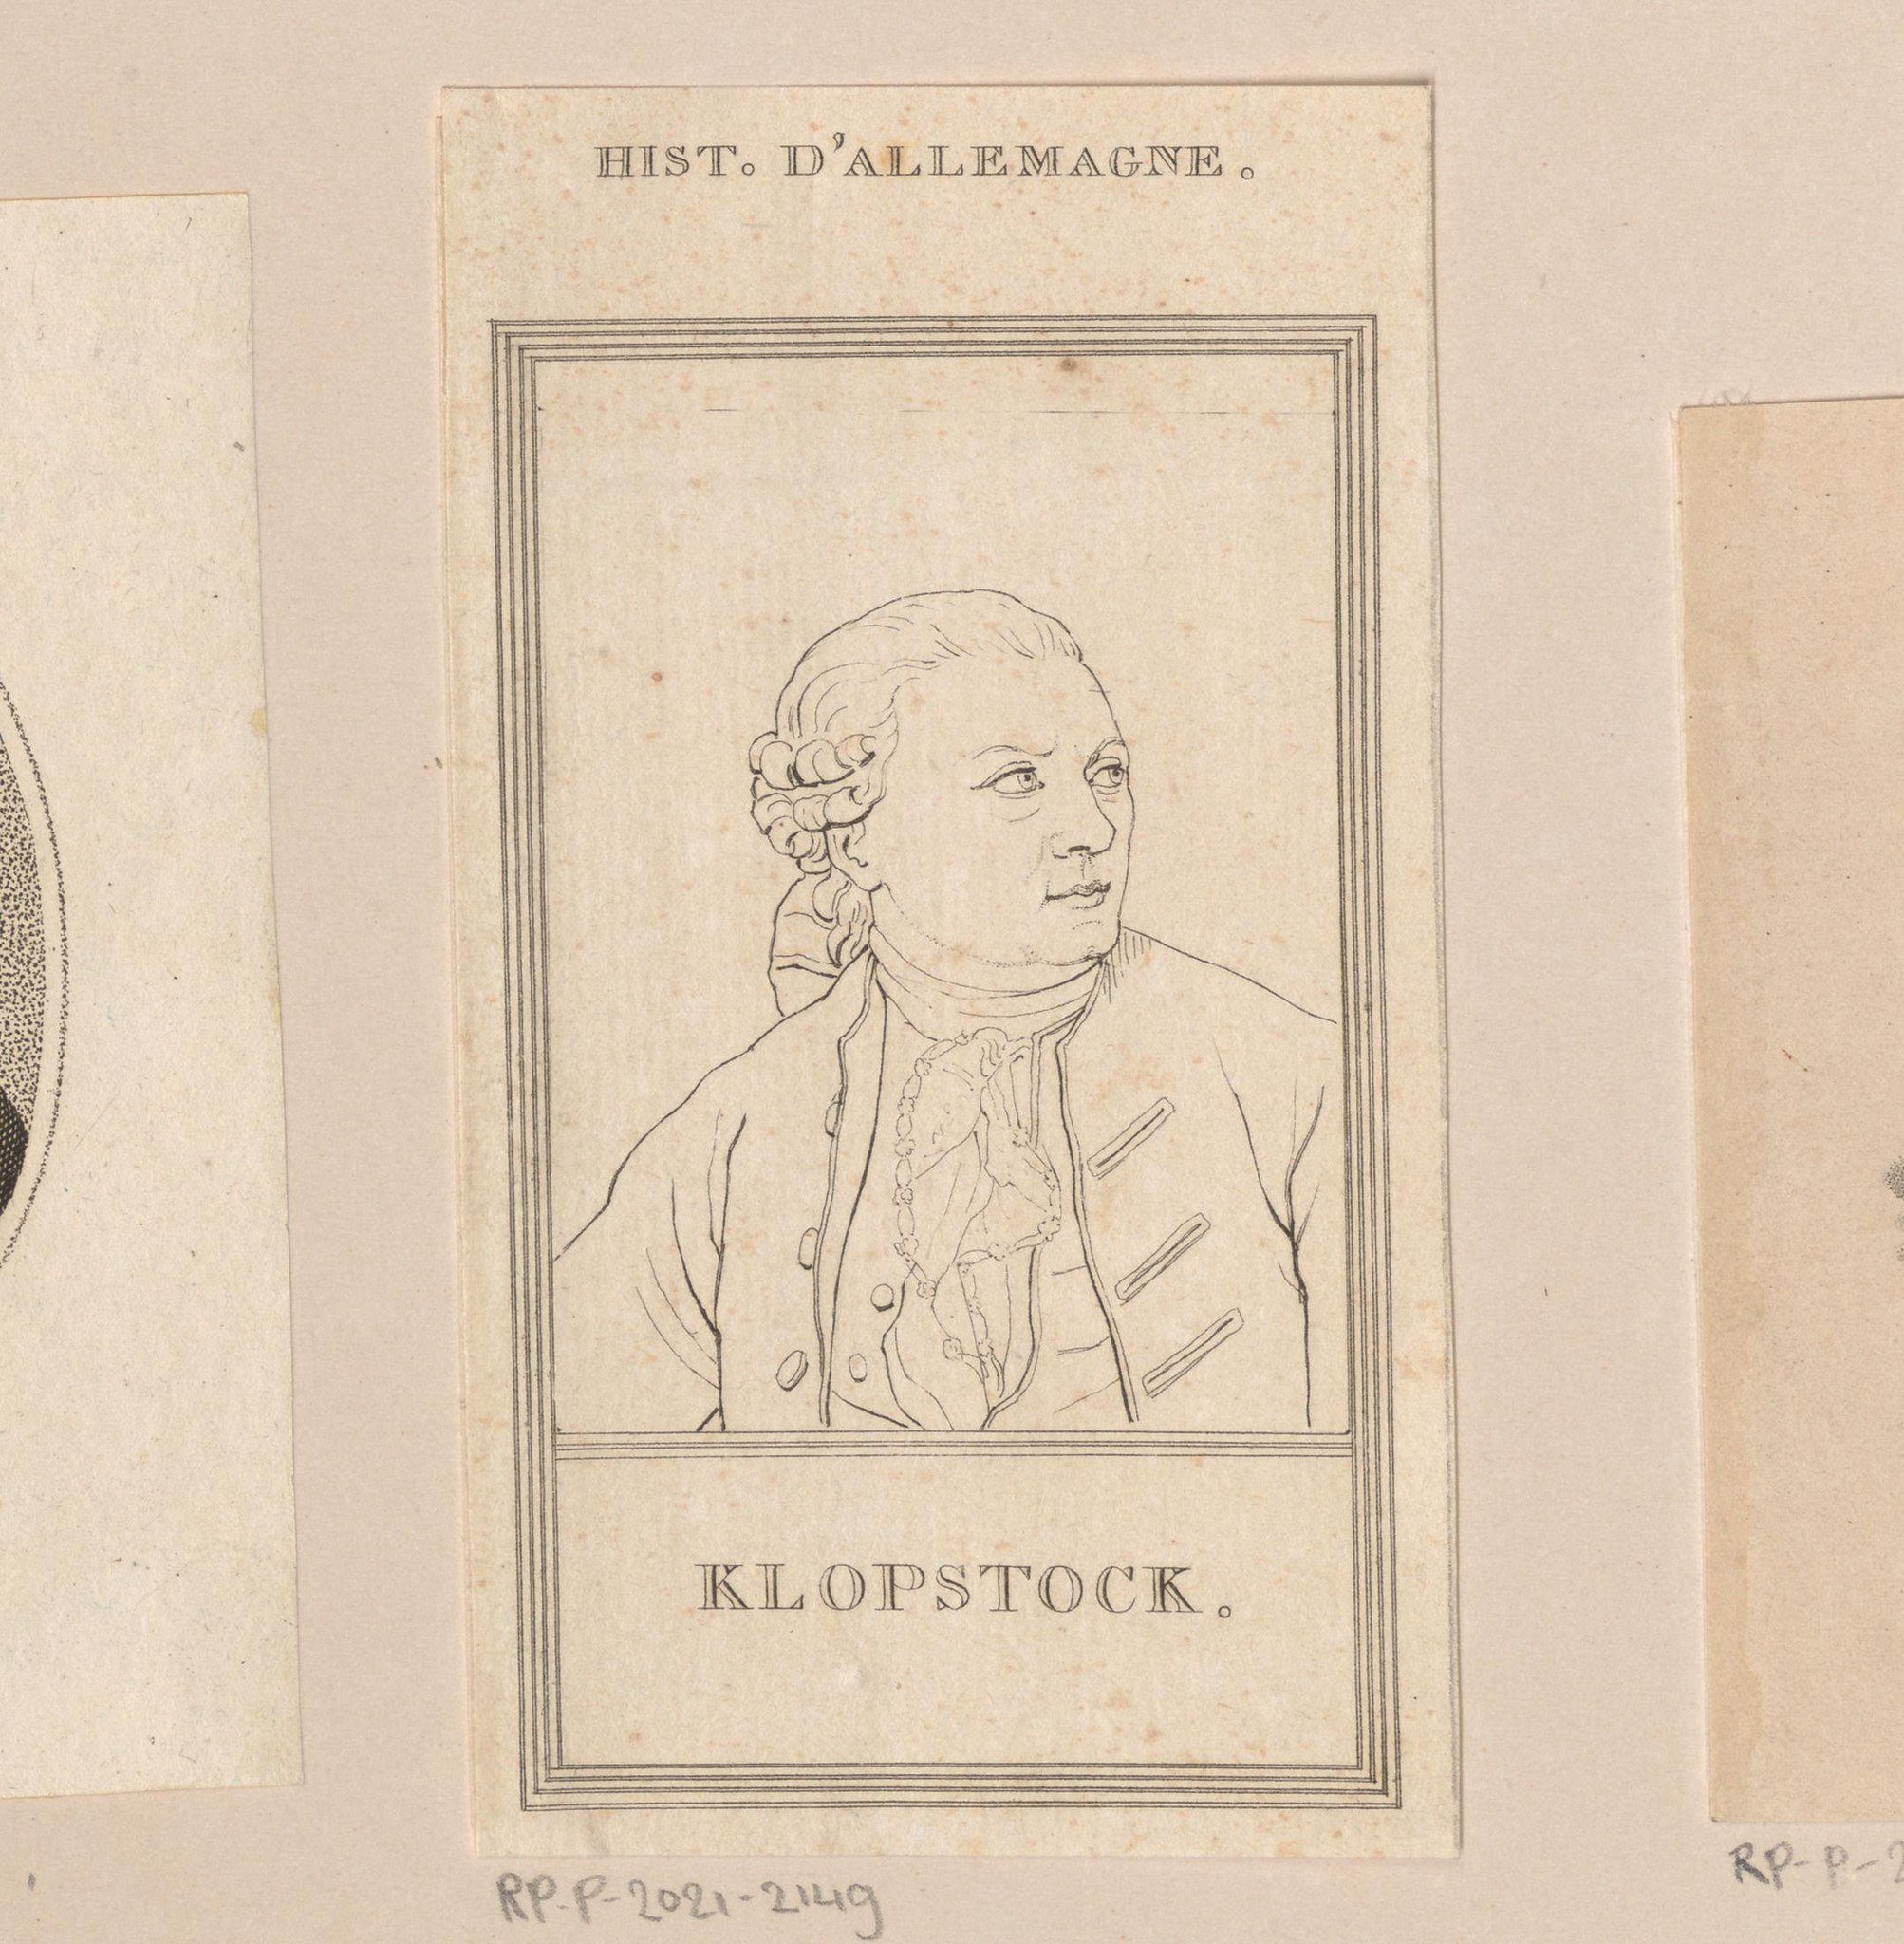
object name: print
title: Portret van Friedrich Gottlieb Klopstock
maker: Anonymous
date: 1811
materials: paper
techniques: etching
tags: historical persons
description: Prent mogelijk uit: Galerie historique des hommes les plus célèbres (...). Parijs: Charles Paul Landon, 1811, dl. 13.